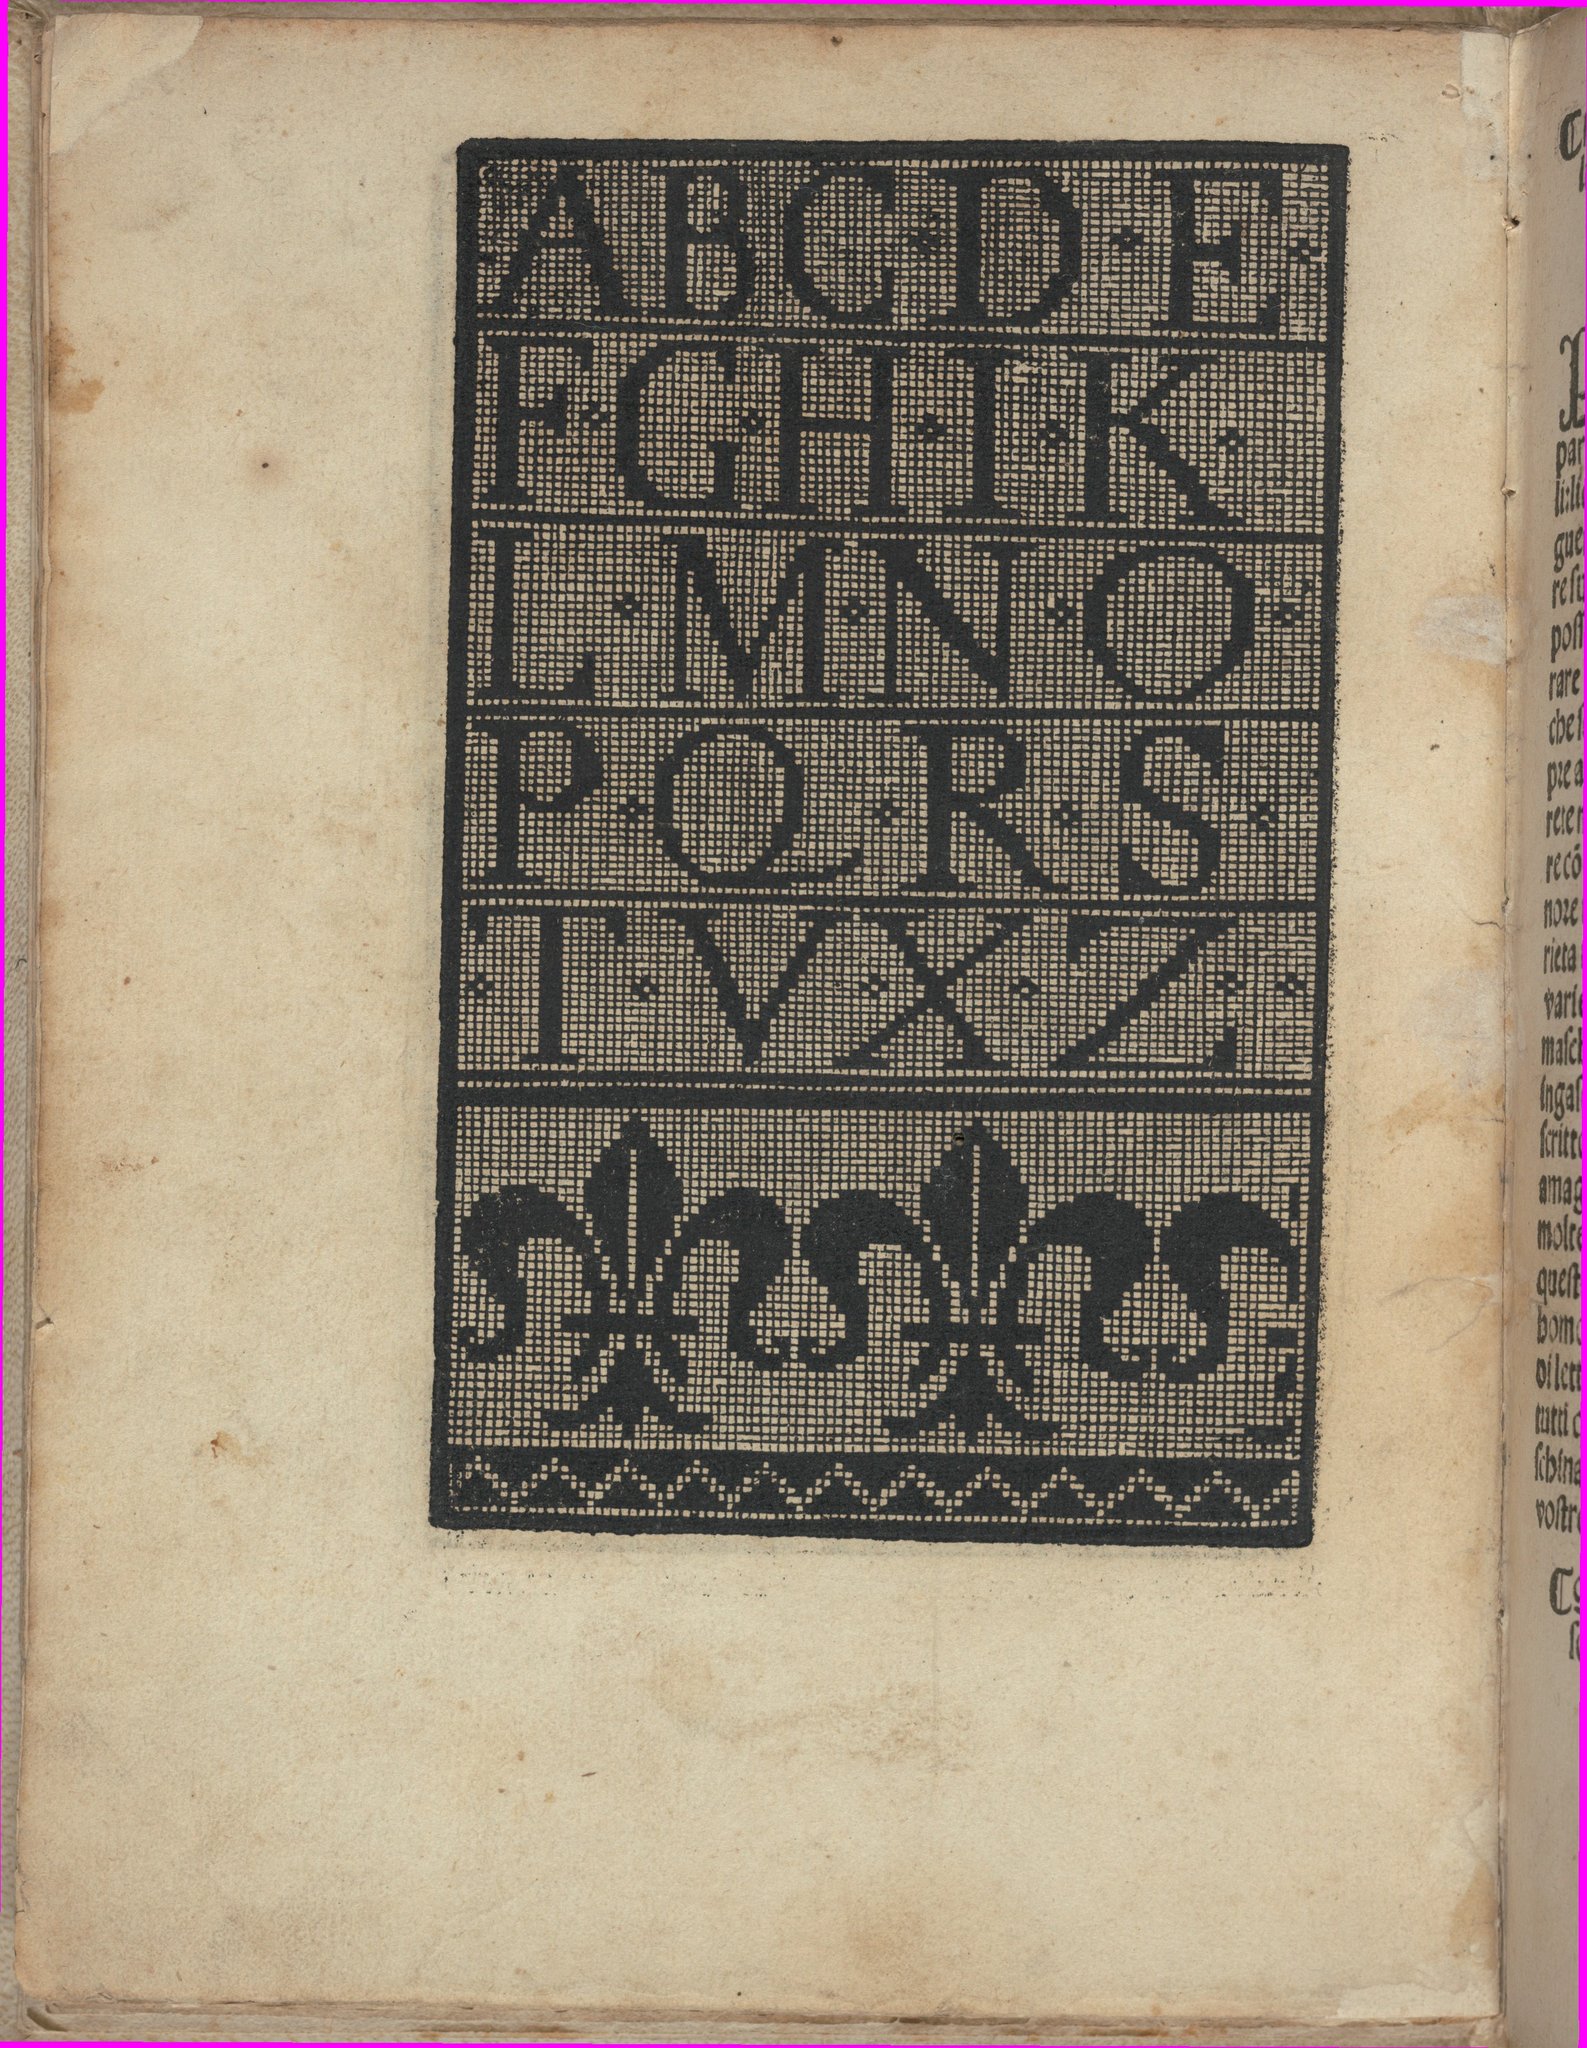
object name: book print ornament architecture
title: Esemplario di Lauori..., page 14 (recto)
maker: giovanni andrea vavassore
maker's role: publisher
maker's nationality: italian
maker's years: 1530-1573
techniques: woodcut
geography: venice